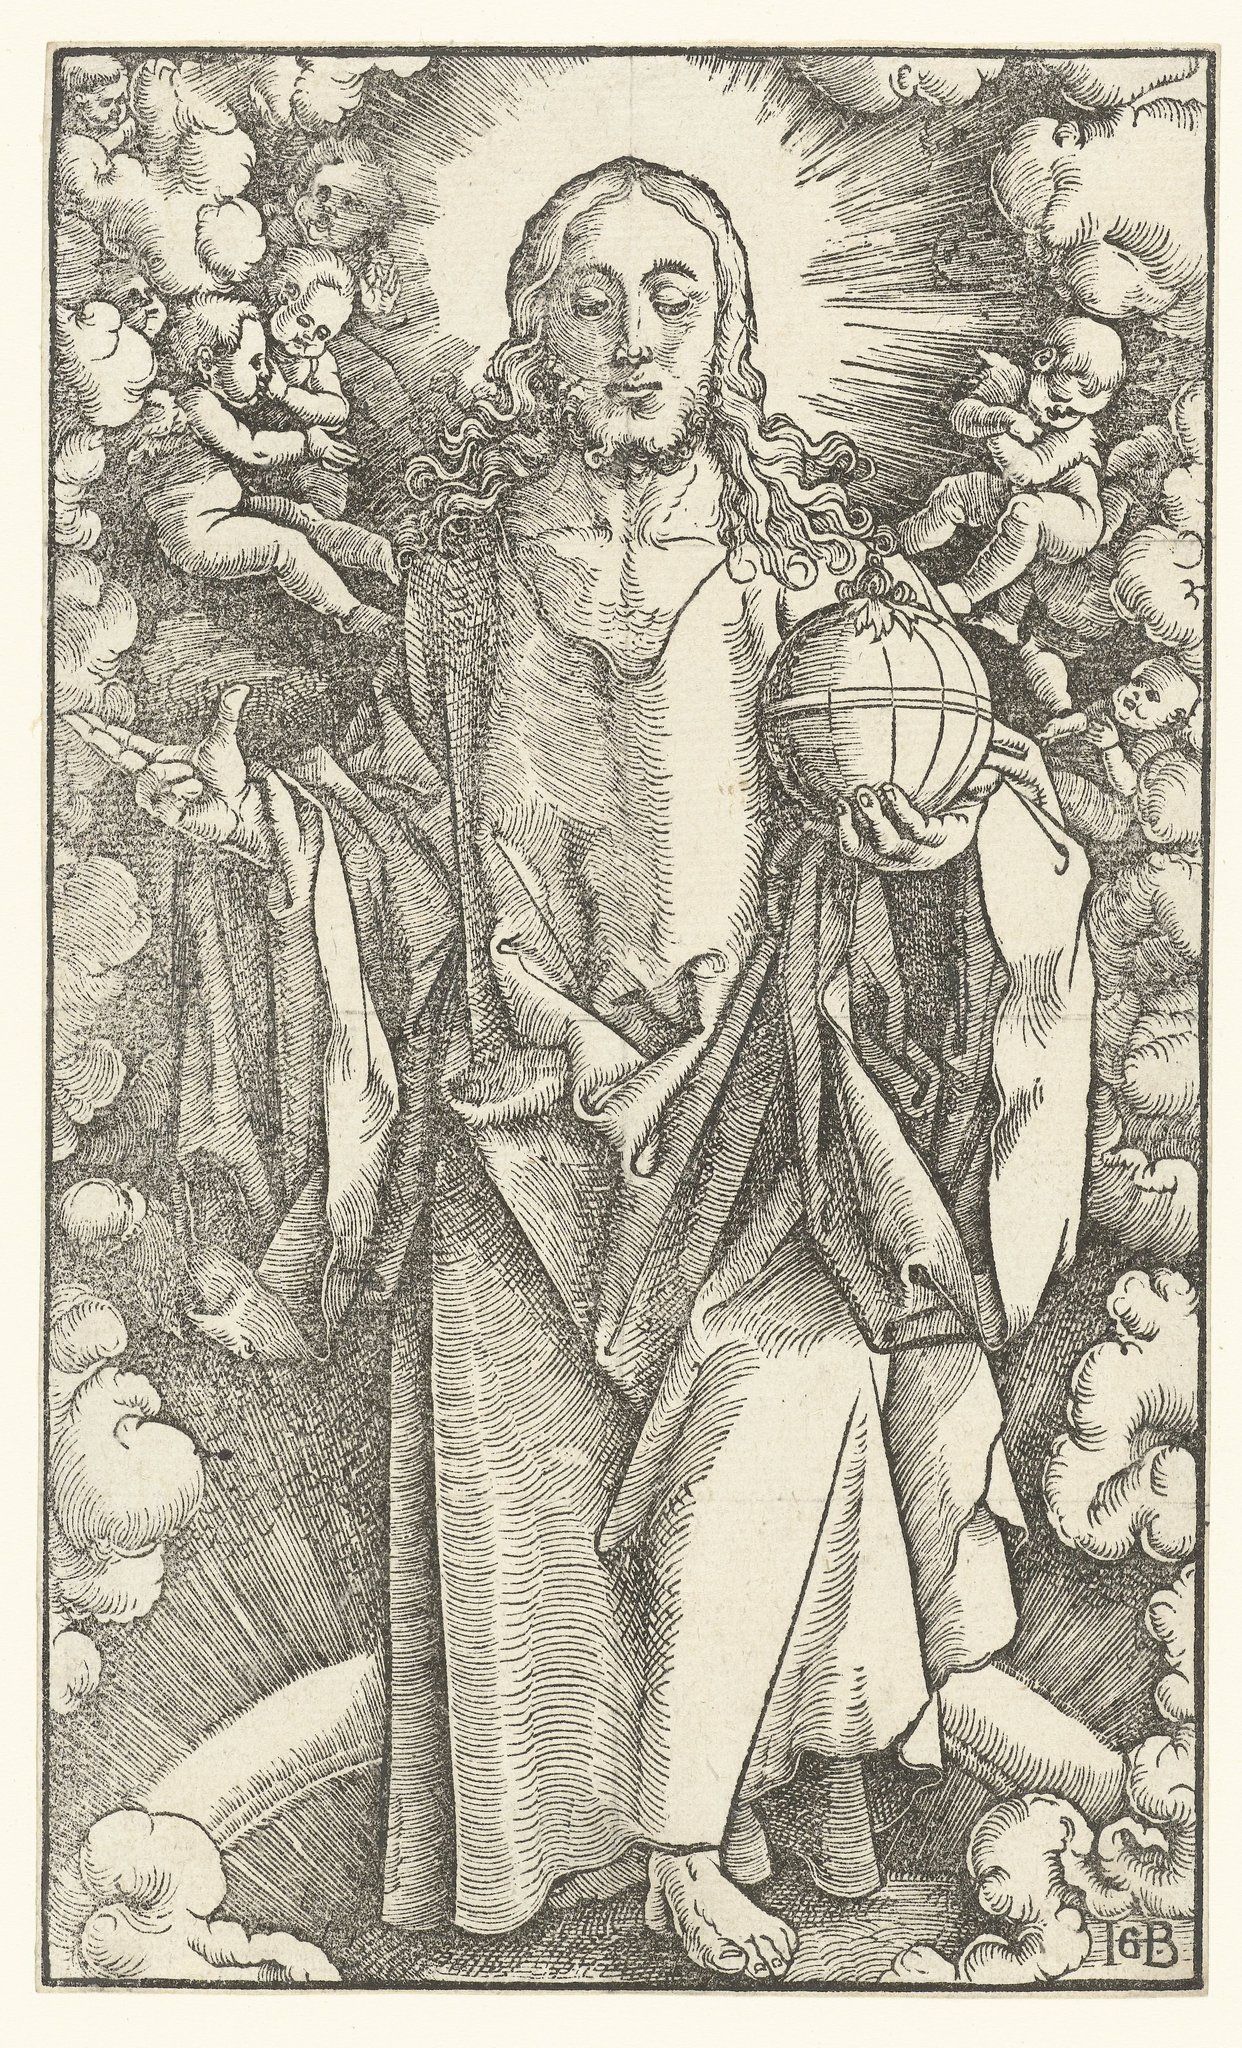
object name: print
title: Christus en de apostelen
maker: hans baldung grien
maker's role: draughtsman, print maker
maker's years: 1484-1545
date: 1519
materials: paper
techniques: woodcut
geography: straatsburg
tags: 'salvator mundi', making a blessing gesture; an orb in his hand or at his feet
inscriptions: collector's mark: Lugt 2228a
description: Christus als Salvator Mundi. Hij staat op een regenboog met rijksappel in linkerhand, met zijn rechterhand maakt hij een zegenend gebaar. Hij wordt omringd door wolken met kleine engelen.